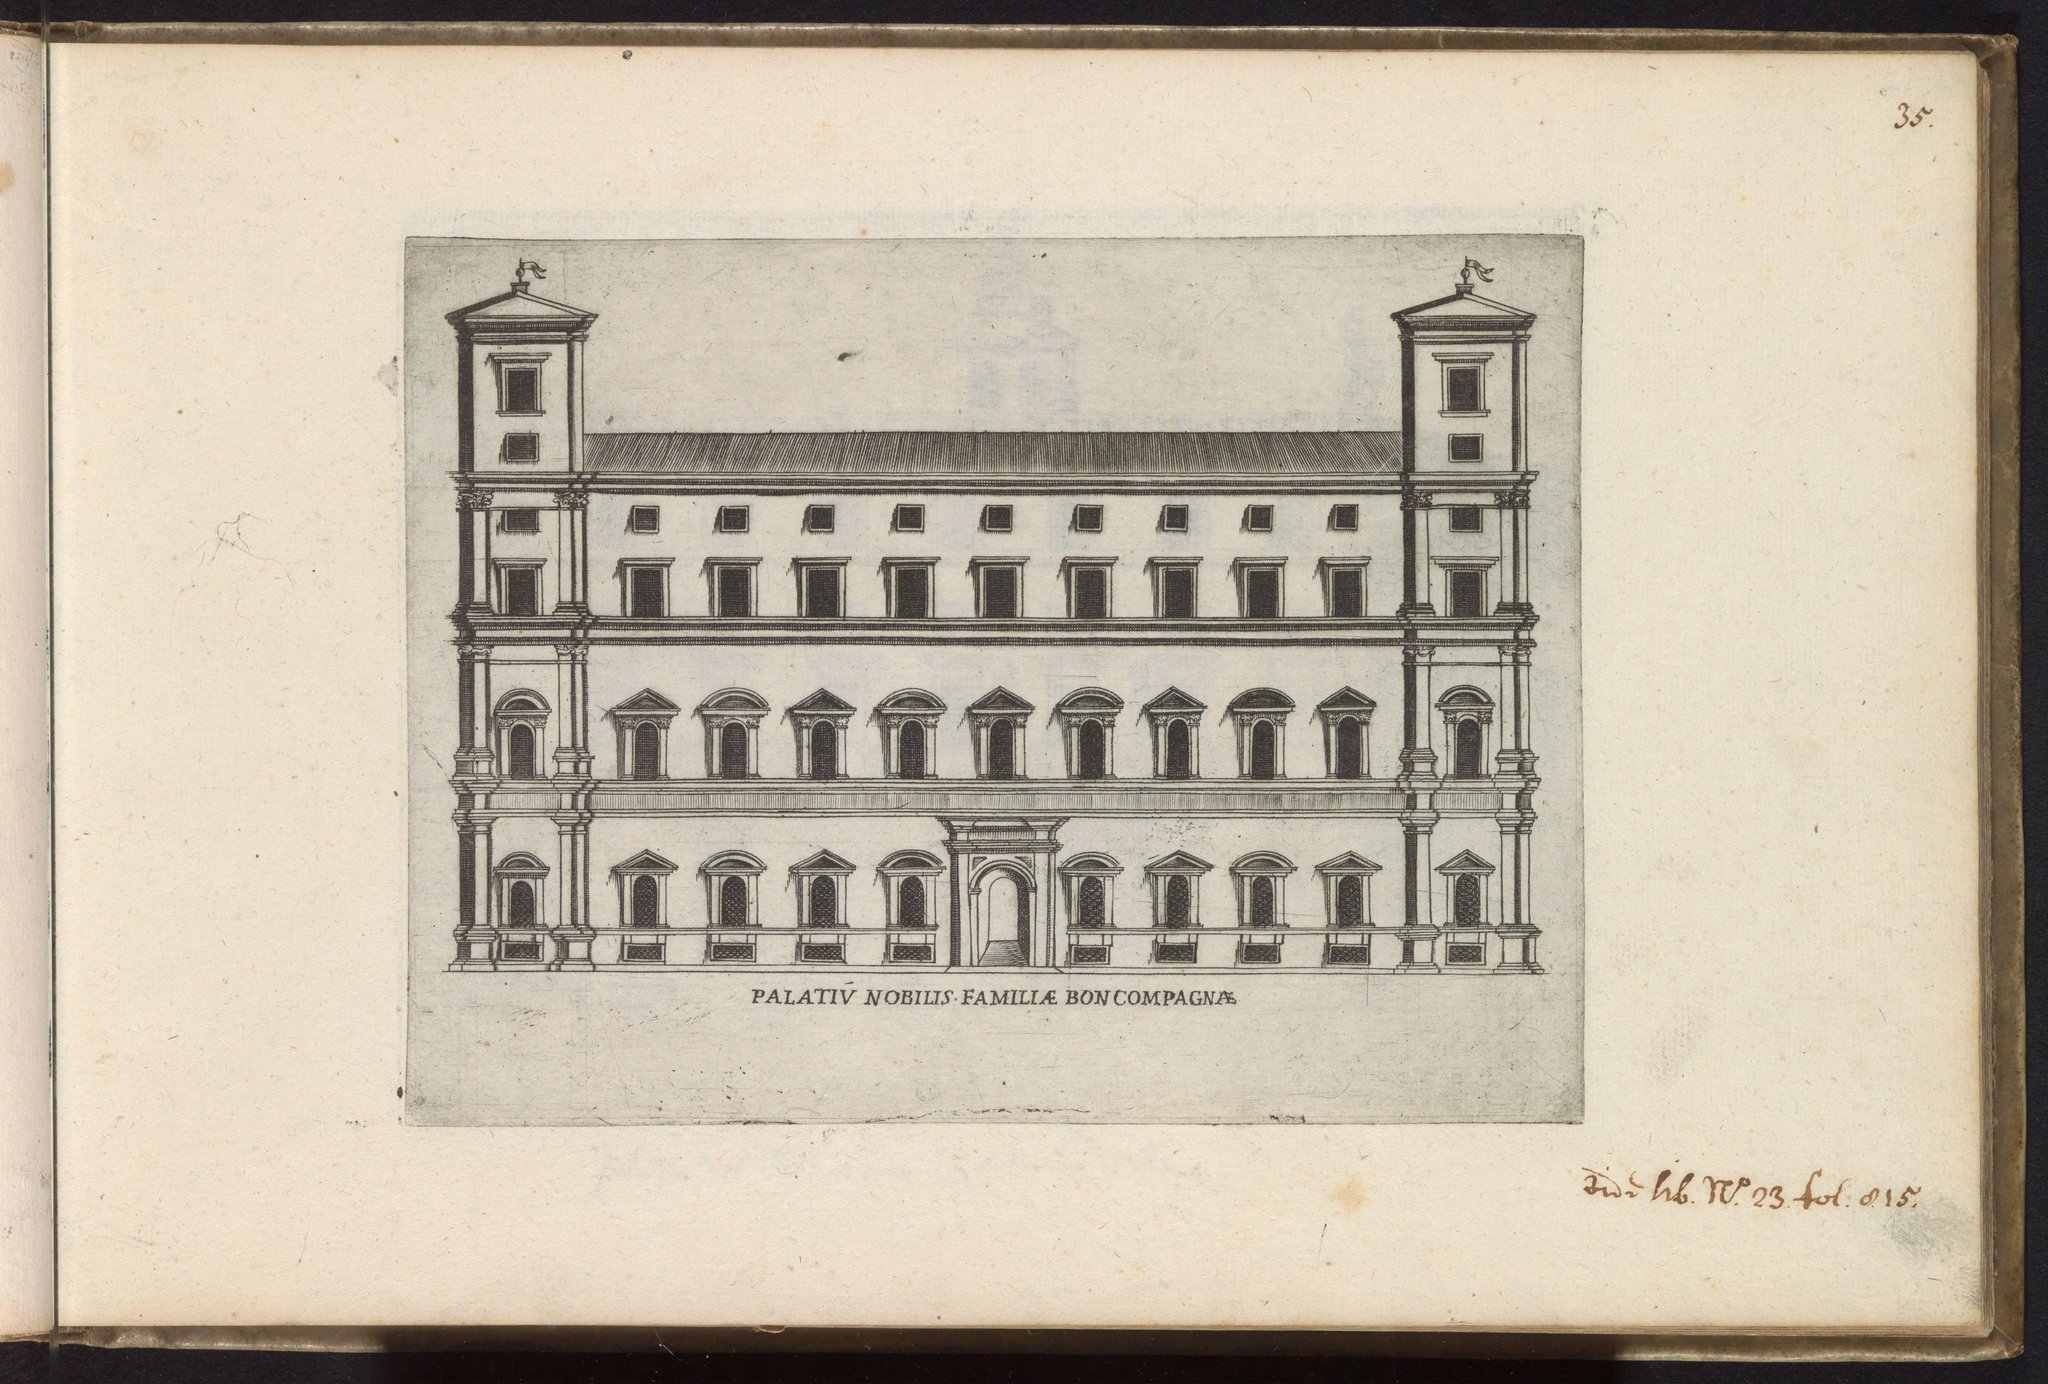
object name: album leaf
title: Beroemde gebouwen in Rome en daarbuiten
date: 1638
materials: paper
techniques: etching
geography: rome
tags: hôtel, i.e. small palace in city, façade (of house or building)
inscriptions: number: ‘35’, inscription: ‘Ende lib. No. 23. fol. 815.’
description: Prent maakt deel uit van een reeks prenten (+ titelprent) van beroemde gebouwen in Rome en elders.